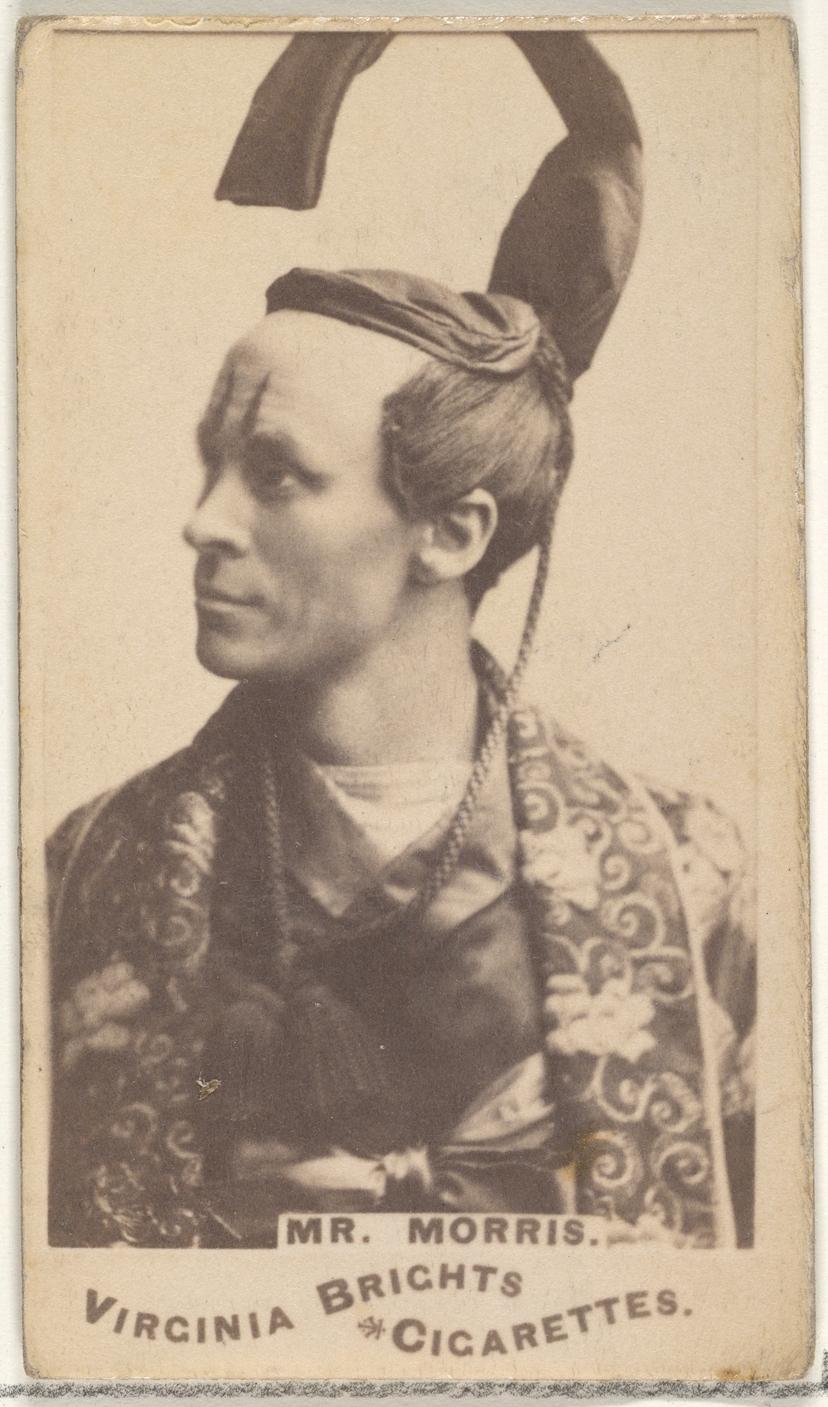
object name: photograph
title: Mr. Morris, from the Actors and Actresses series (N45, Type 1) for Virginia Brights Cigarettes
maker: allen & ginter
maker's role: publisher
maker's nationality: american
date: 1888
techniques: albumen silver print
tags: men,portraits,actors